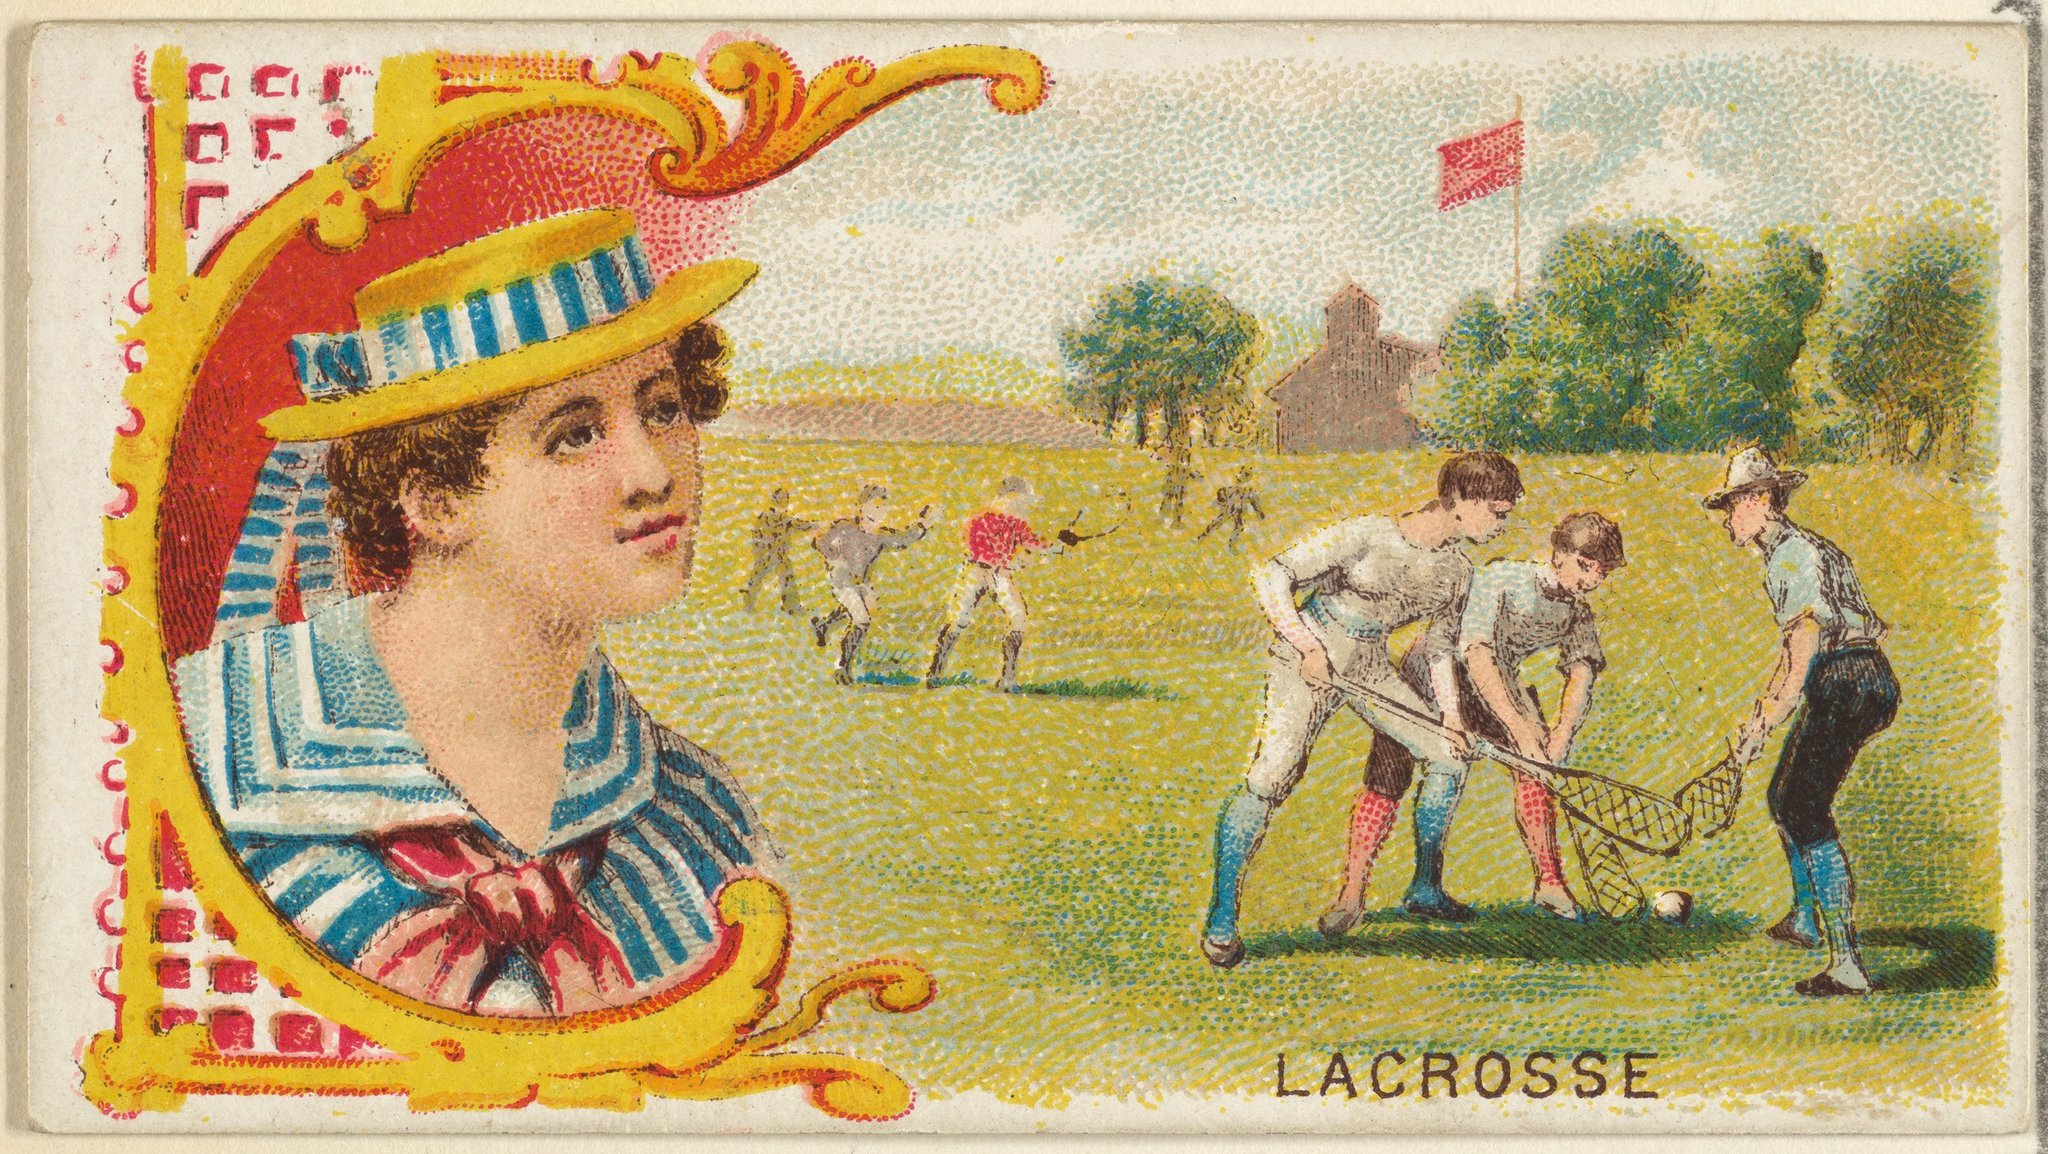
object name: print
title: Lacrosse, from the Games and Sports series (N165) for Old Judge Cigarettes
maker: goodwin & company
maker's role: publisher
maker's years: 1850-1950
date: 1889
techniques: color lithograph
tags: men,women,sports